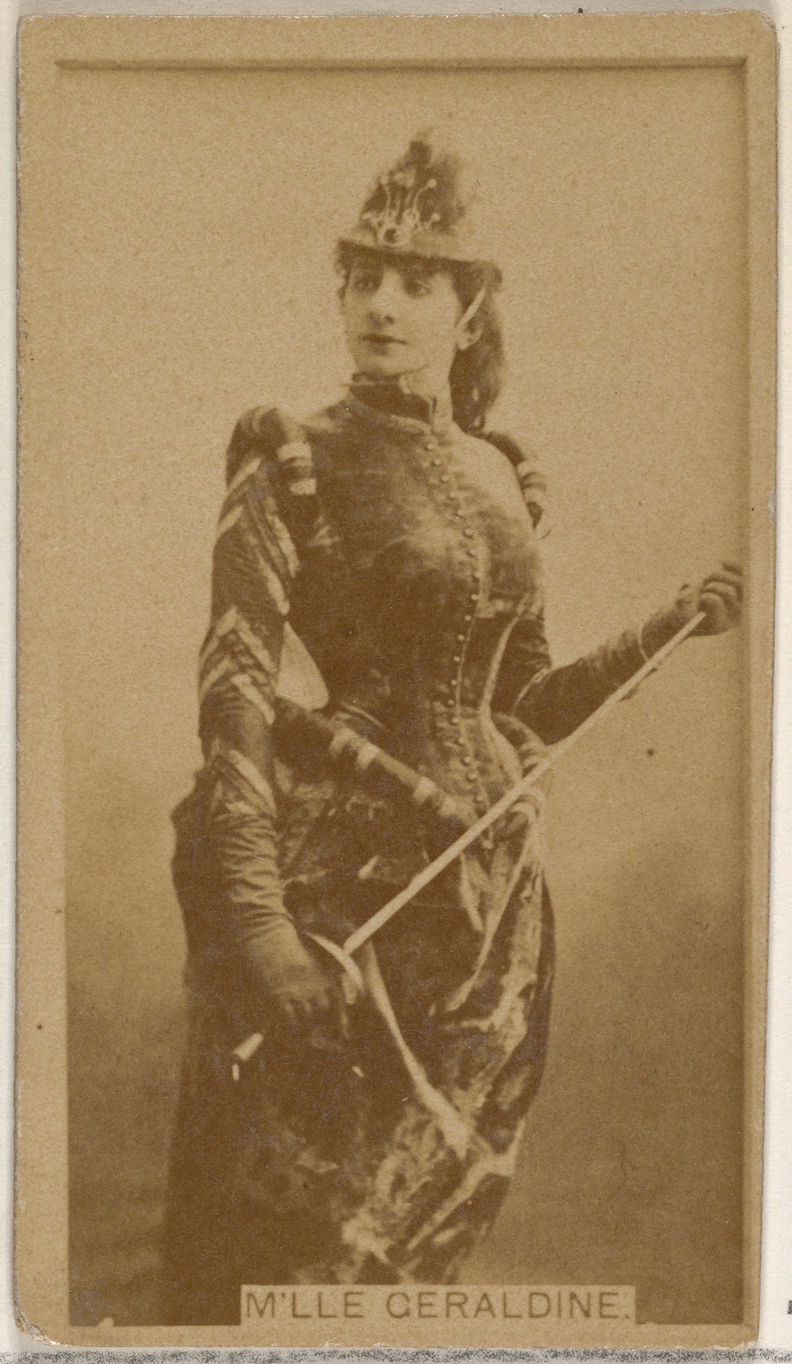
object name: photograph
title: M'lle Geraldine, from the Actors and Actresses series (N45, Type 8) for Virginia Brights Cigarettes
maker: allen & ginter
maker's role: publisher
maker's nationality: american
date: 1888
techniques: albumen silver print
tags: portraits,women,actresses